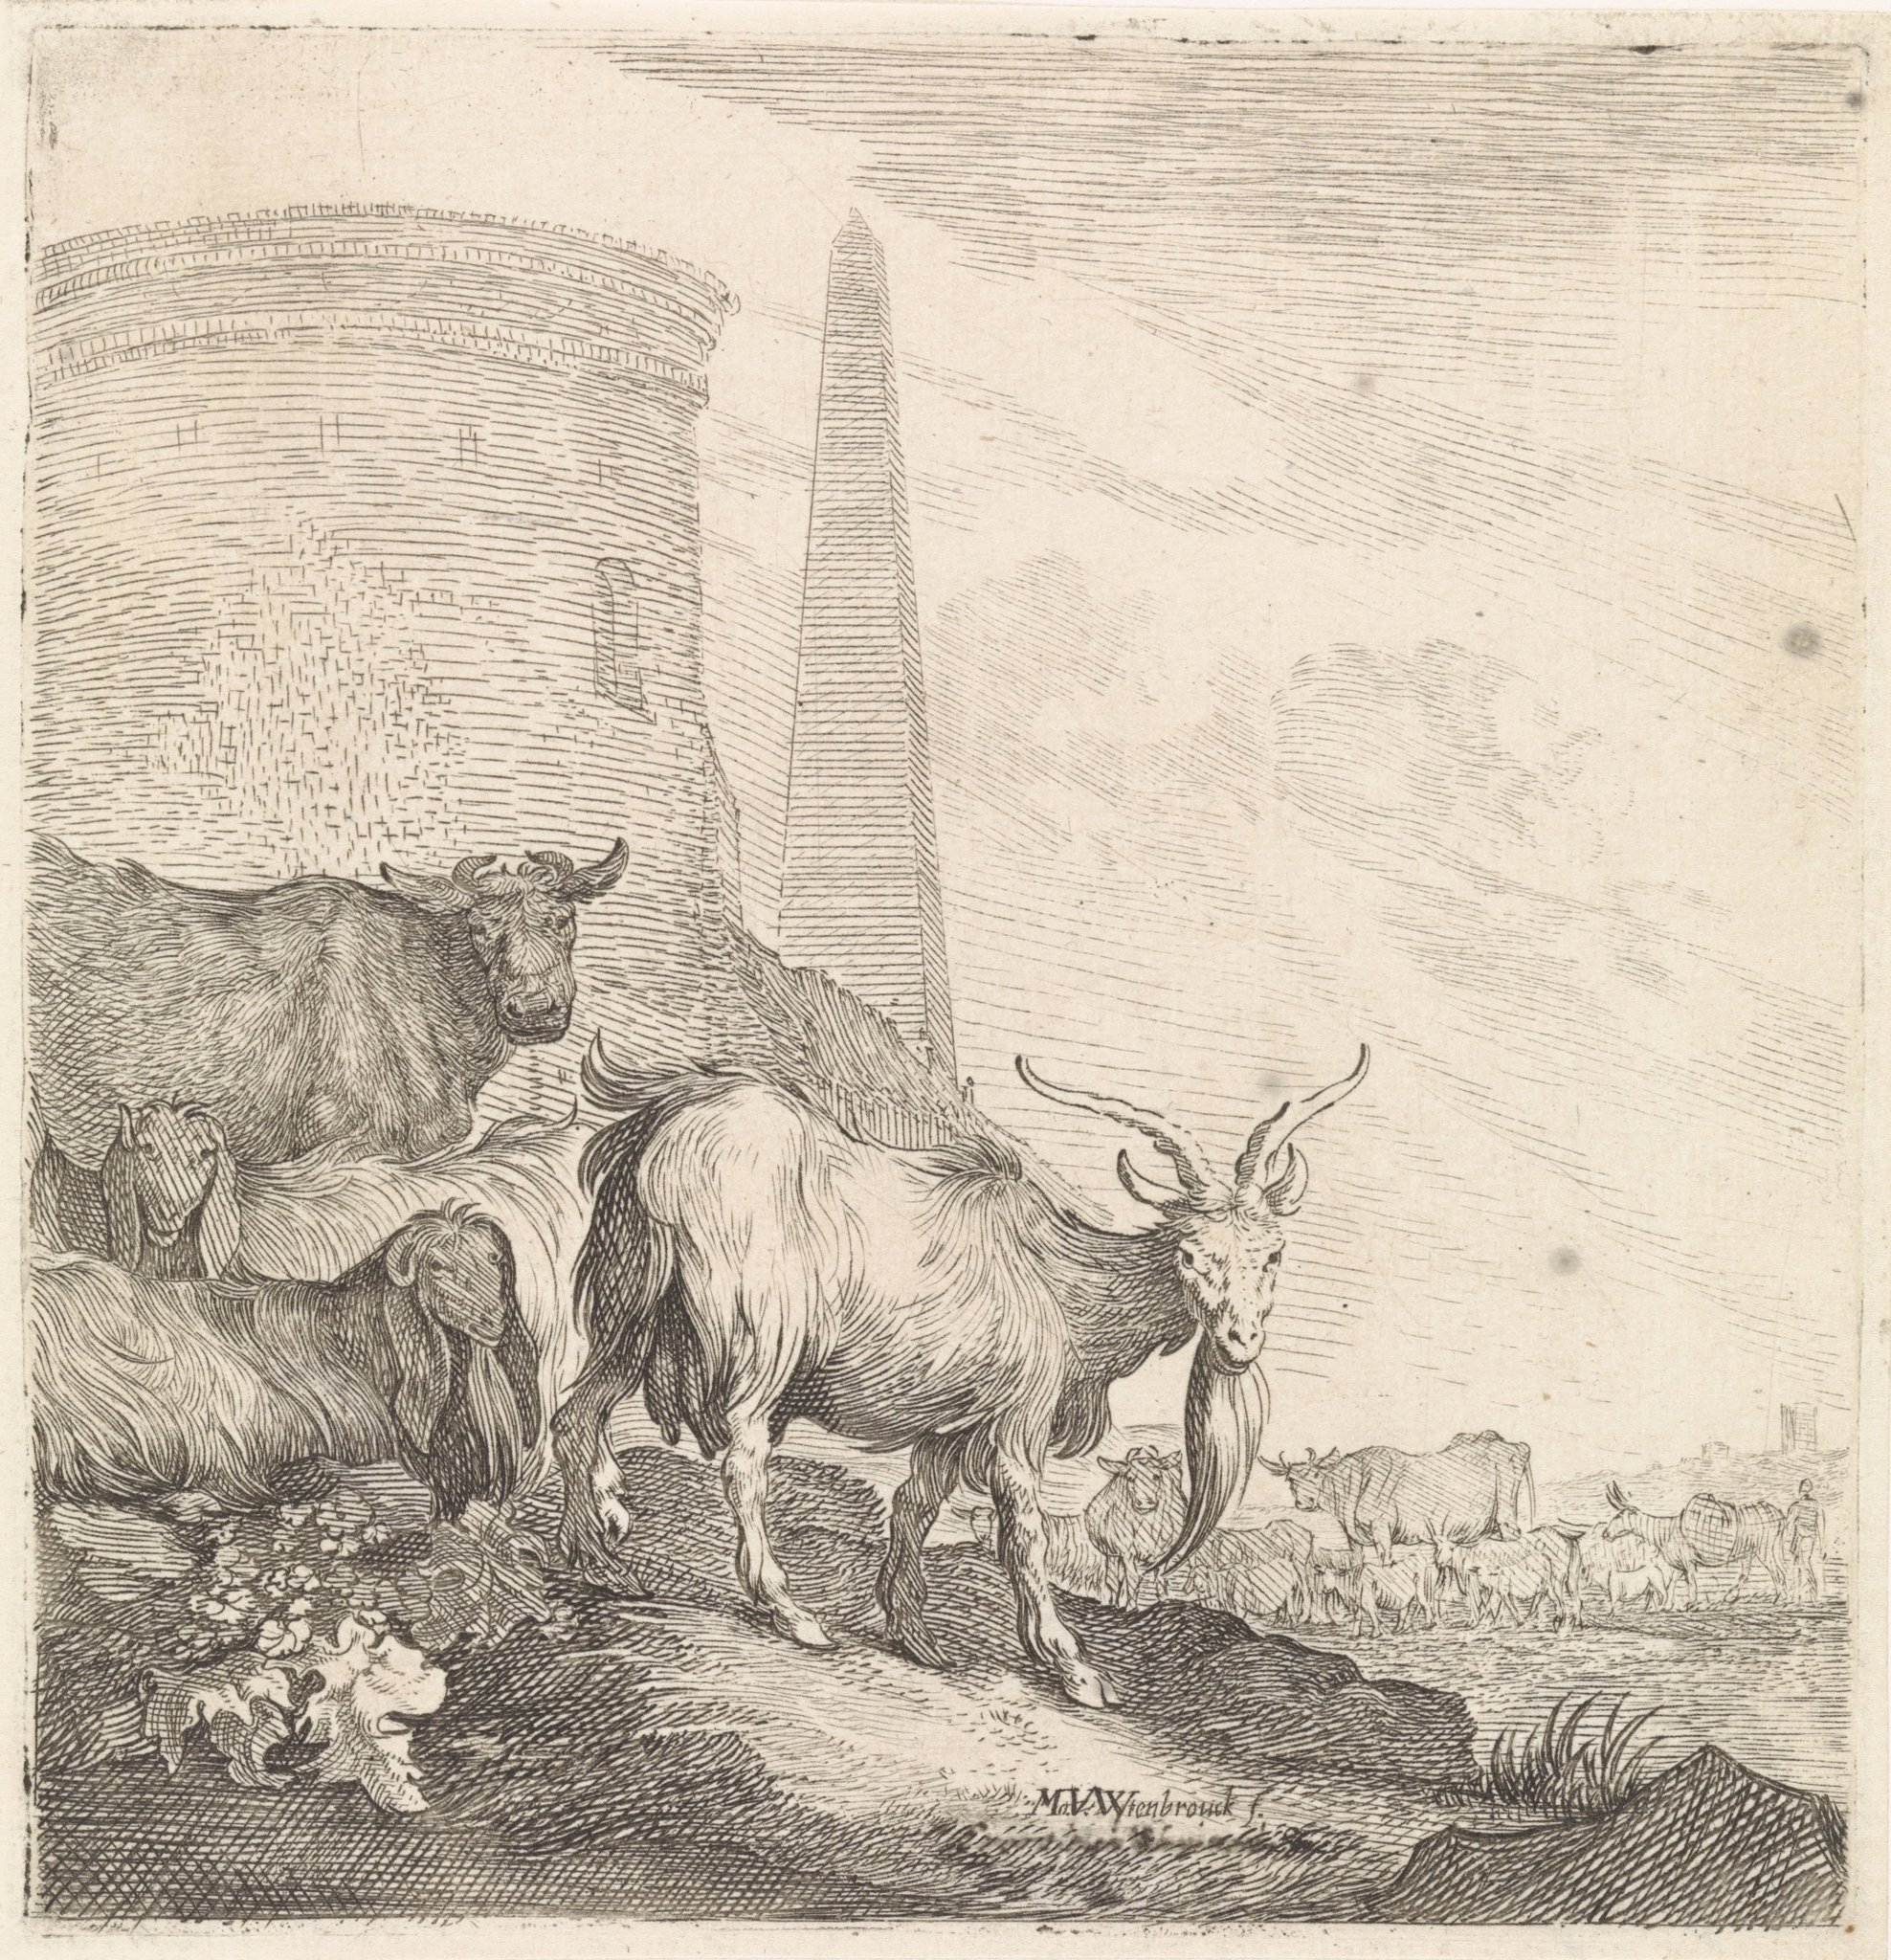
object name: print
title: Geiten en koeien bij een ronde toren met een obelisk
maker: moyses van wtenbrouck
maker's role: painter, print maker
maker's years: 1590-1647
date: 1600-1647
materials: paper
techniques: drypoint, engraving, etching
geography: the hague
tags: bovine cattle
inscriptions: collector's mark: Lugt 2228, collector's mark: Lugt 2610